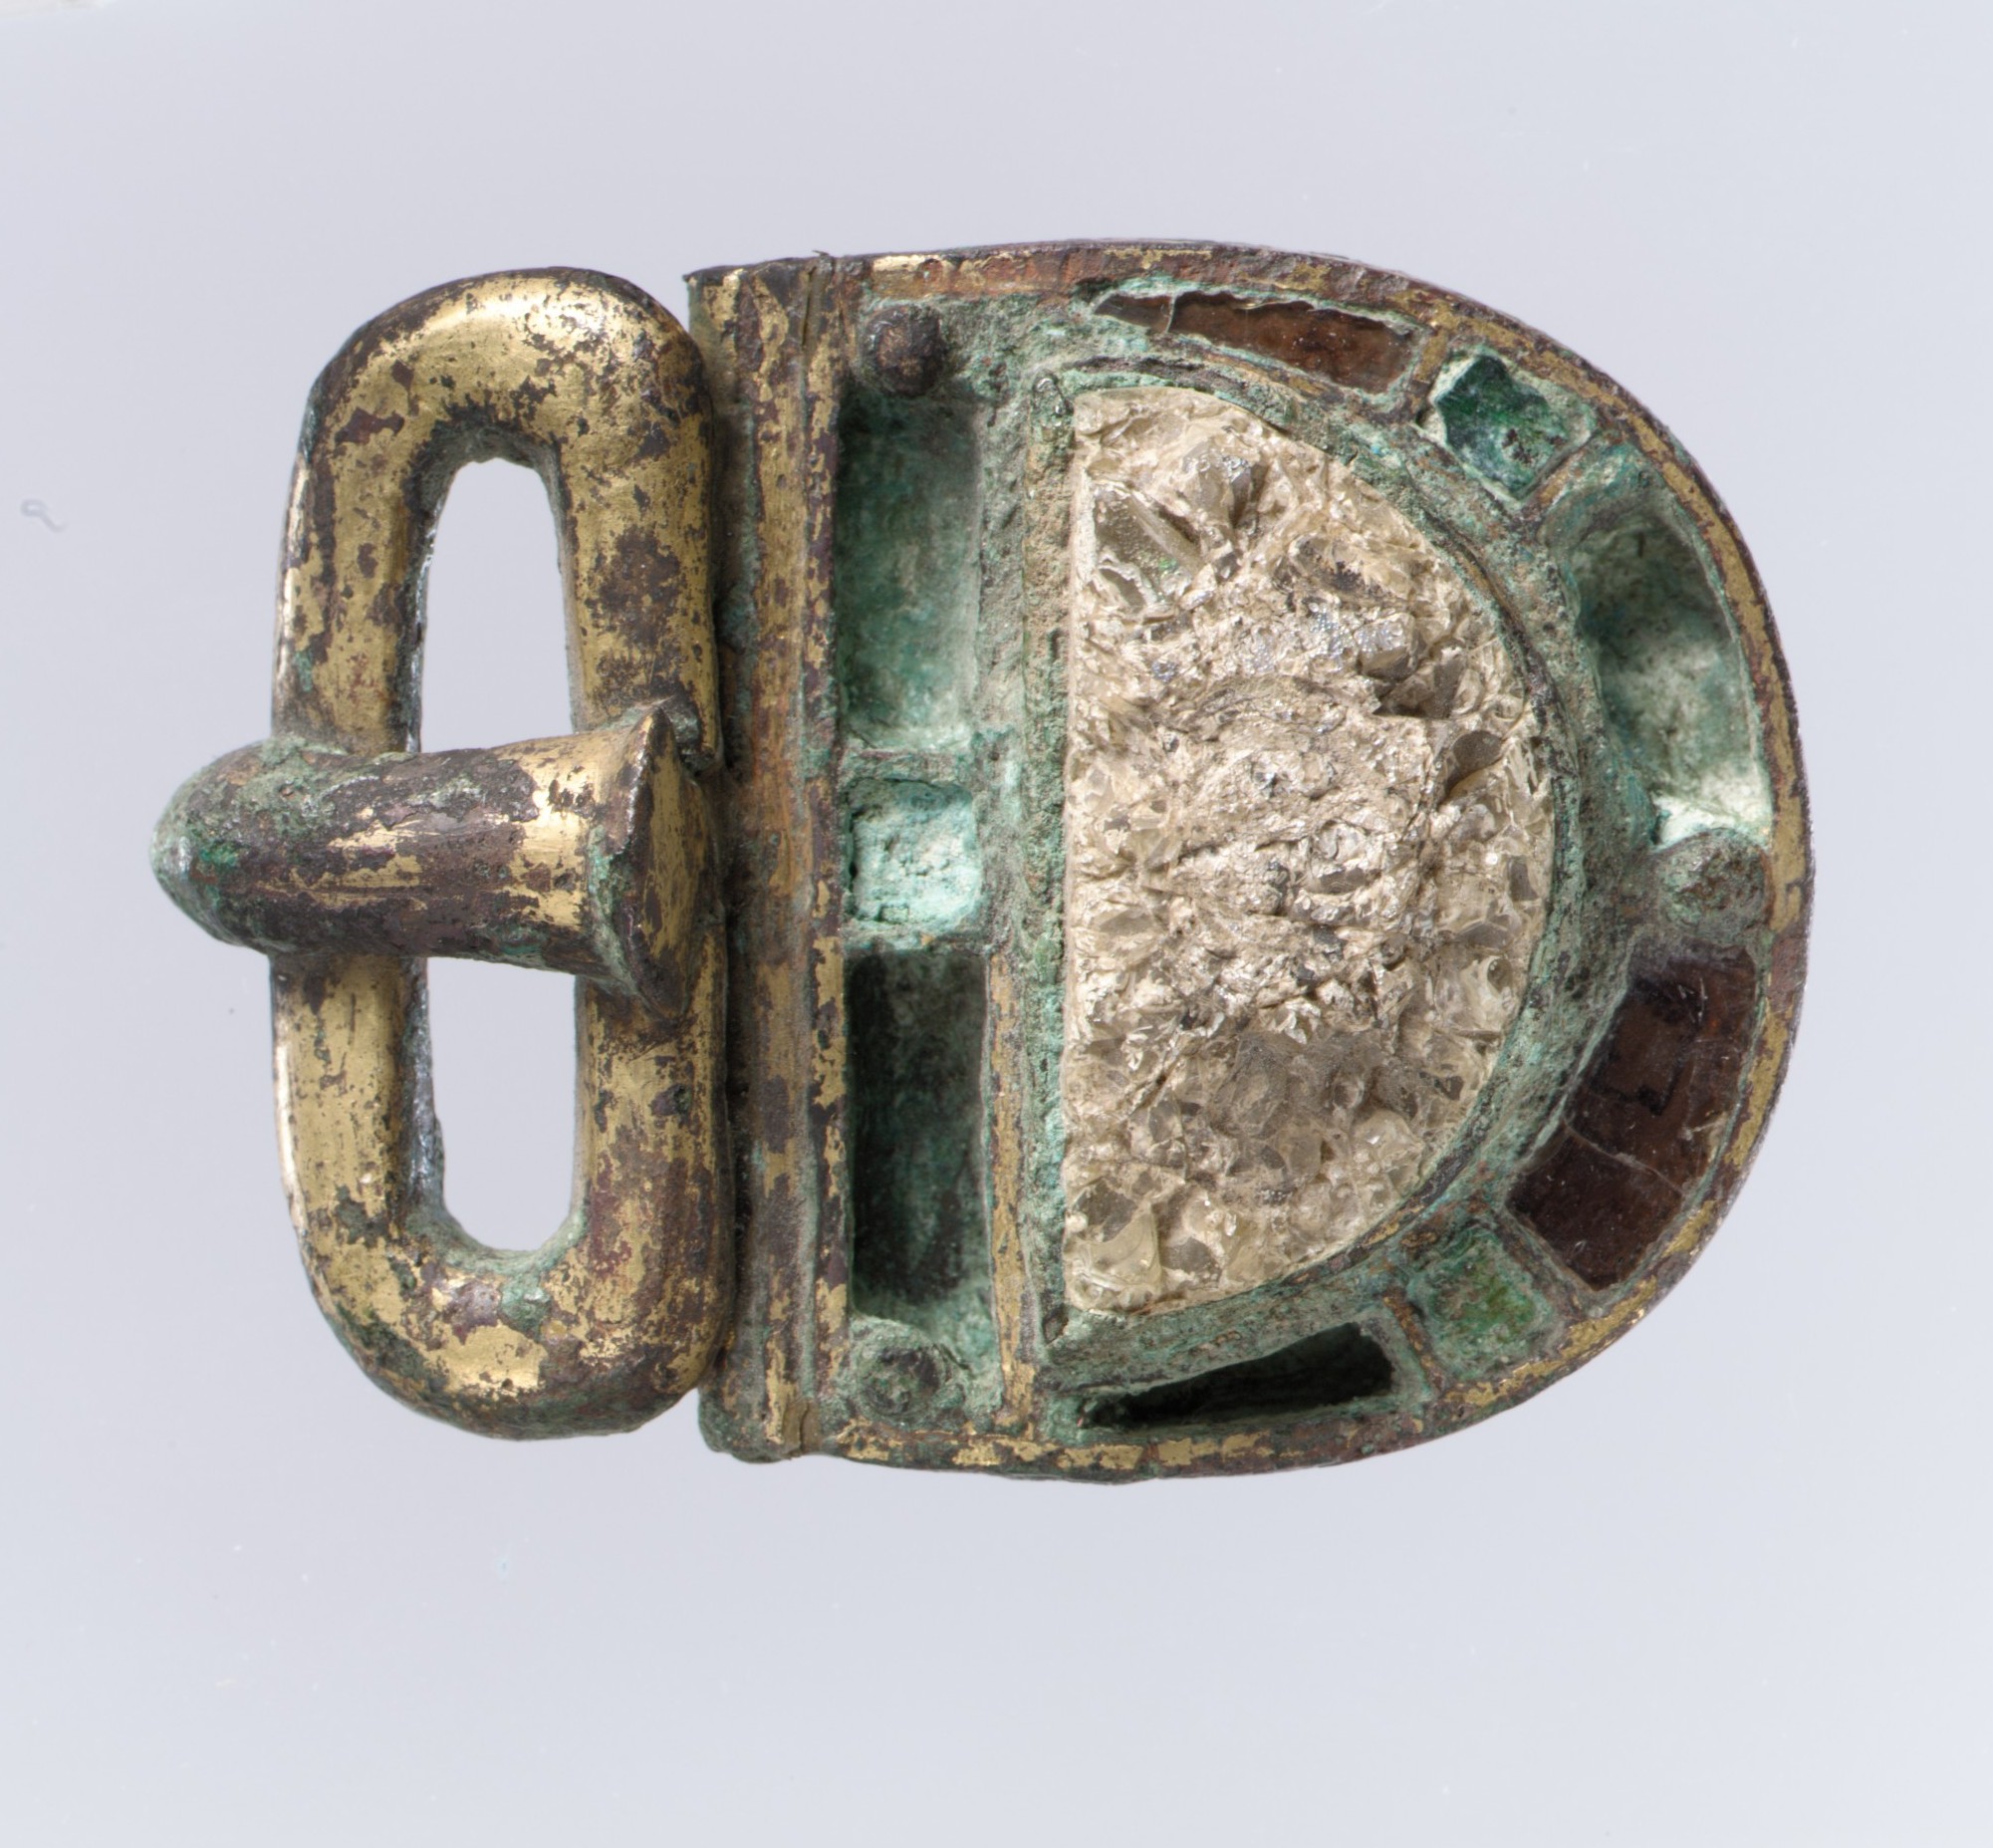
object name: buckle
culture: mediterranean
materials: bronze, garnet, gilt, glass